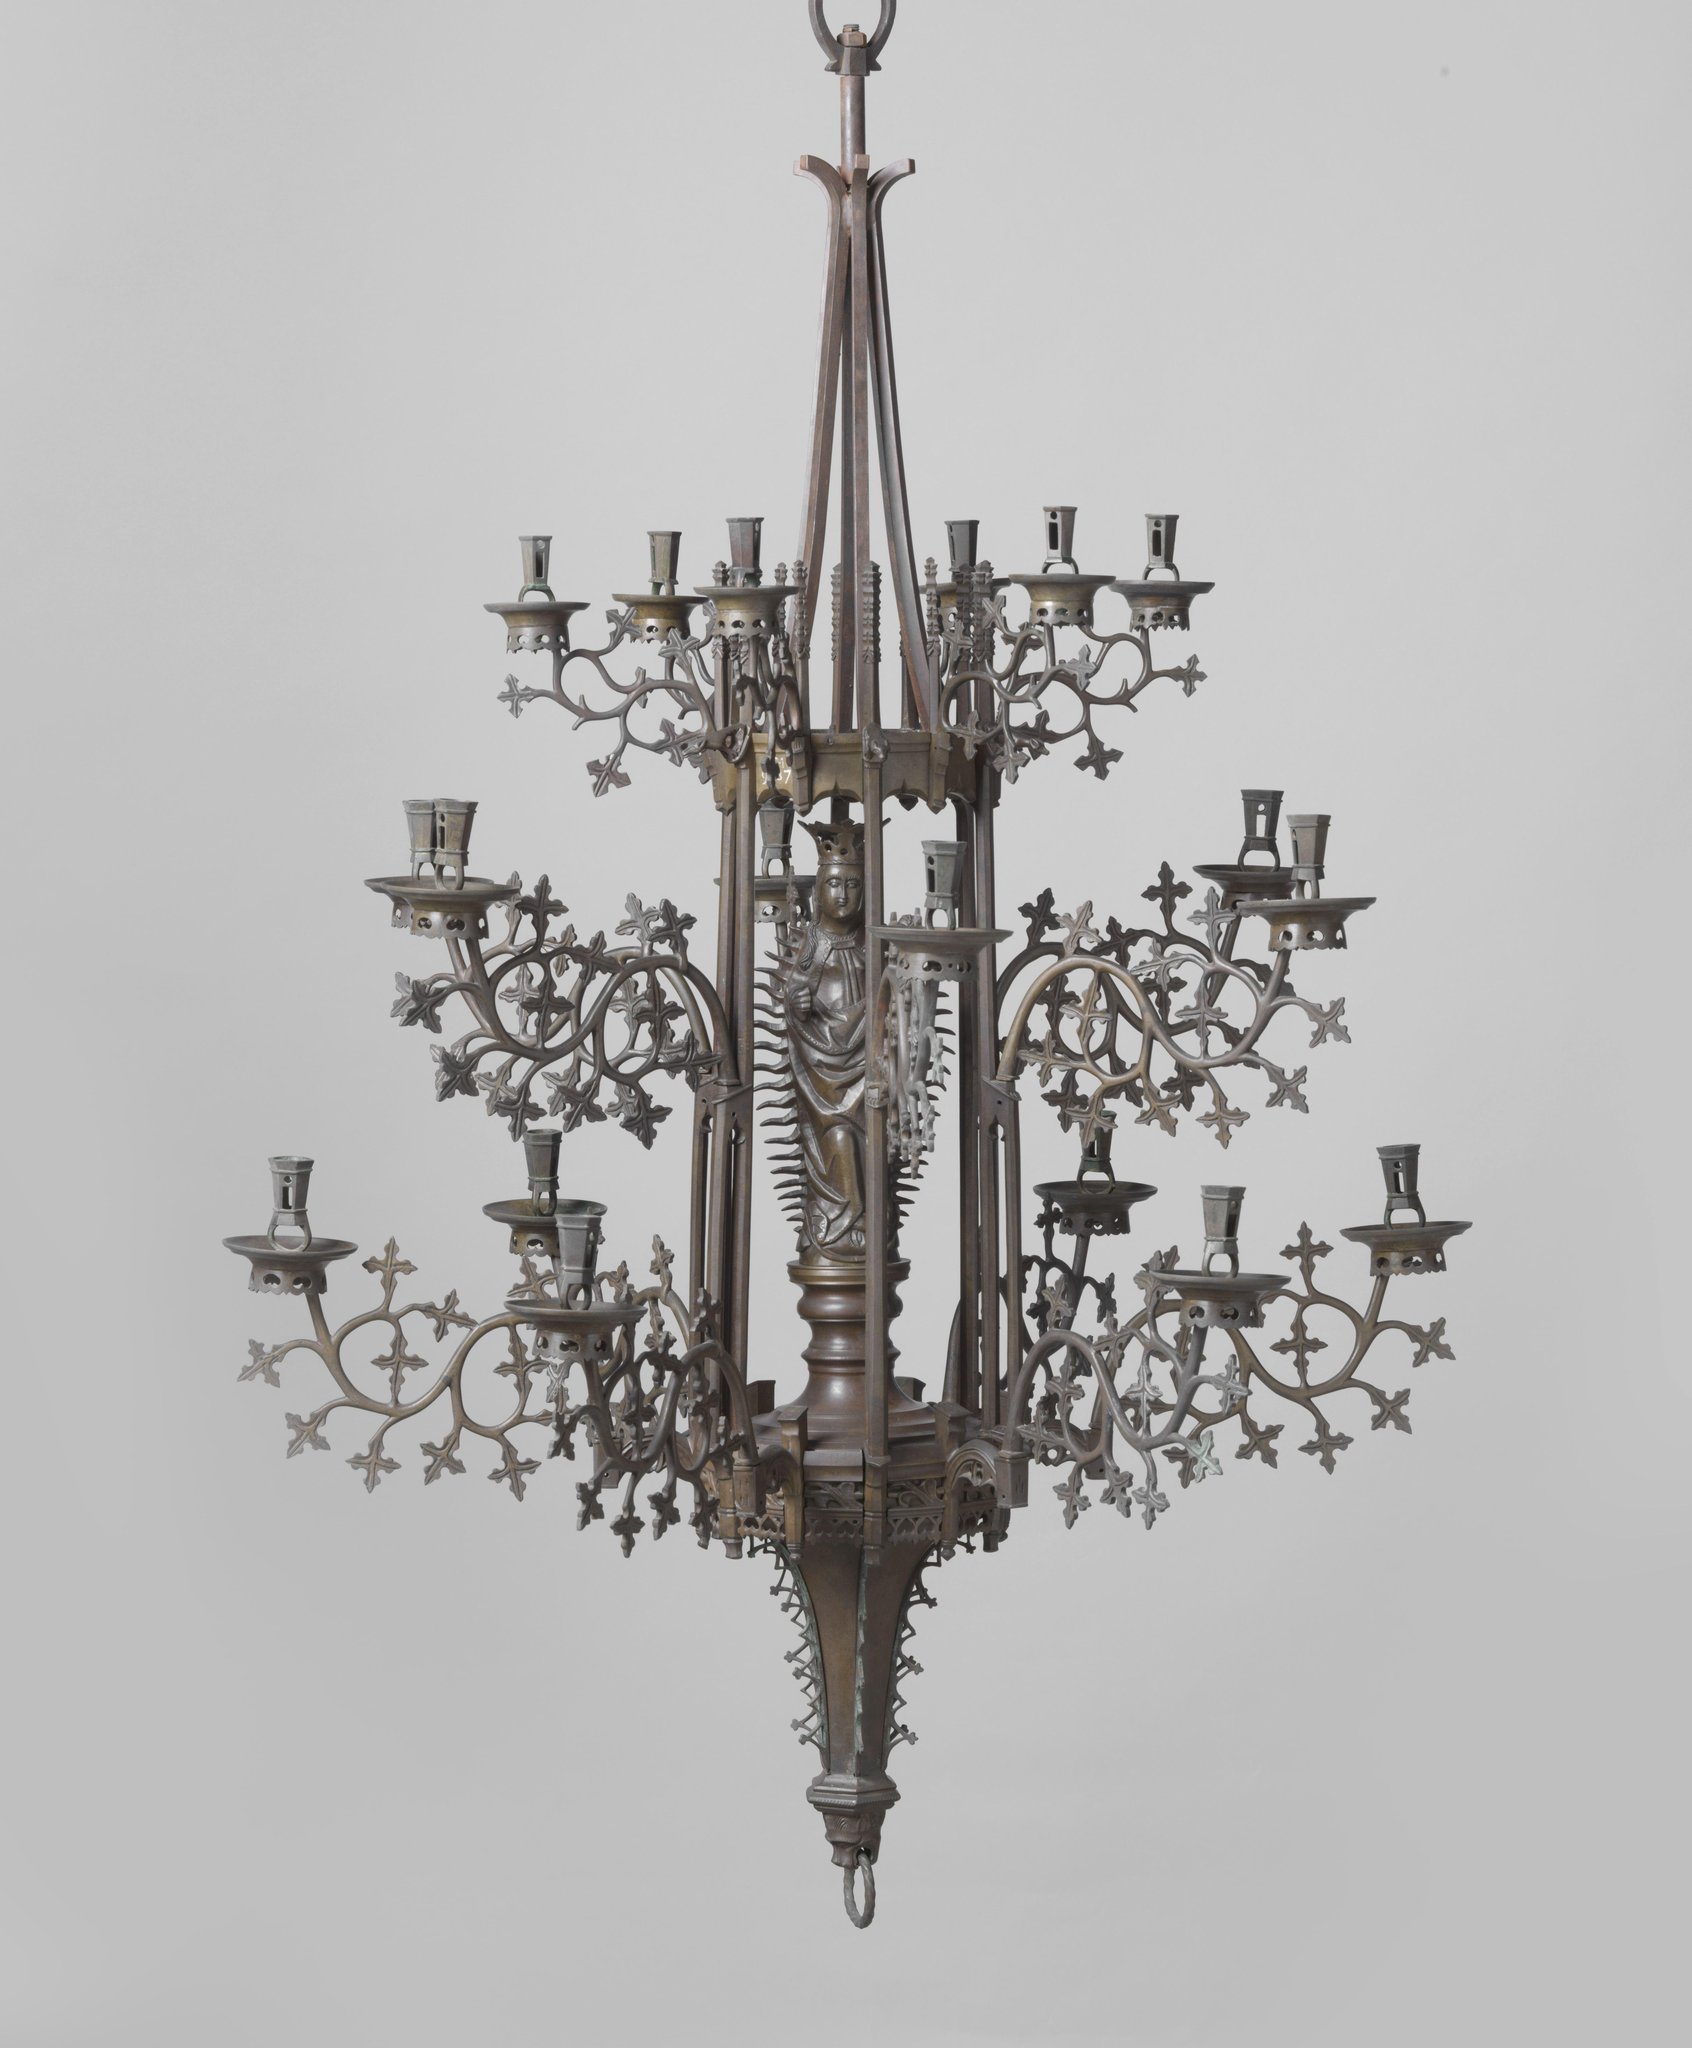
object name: kaarsenarm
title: Kaarsenarm van kaarsenkroon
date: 1475-1485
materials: brass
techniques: casting, metalworking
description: Kaarsenarm behorende bij een kaarsenkroon van drie hoogten met Mariakapel in het midden. De arm is twee maal gebogen en heeft elf bladeren. Aan het uiteinde rust de vetvanger, die aan de onderzijde een verticale gekartelde rand met kruisbloemmotieven heeft. De kaarsenhouder is zesvlakkig met een geperforeerde zijde aan voor- en achterkant en heeft een verticaal ringvormig onderstuk. Dit is de tweede arm van de onderste ring (voetstuk), genummerd met 2 stippen.